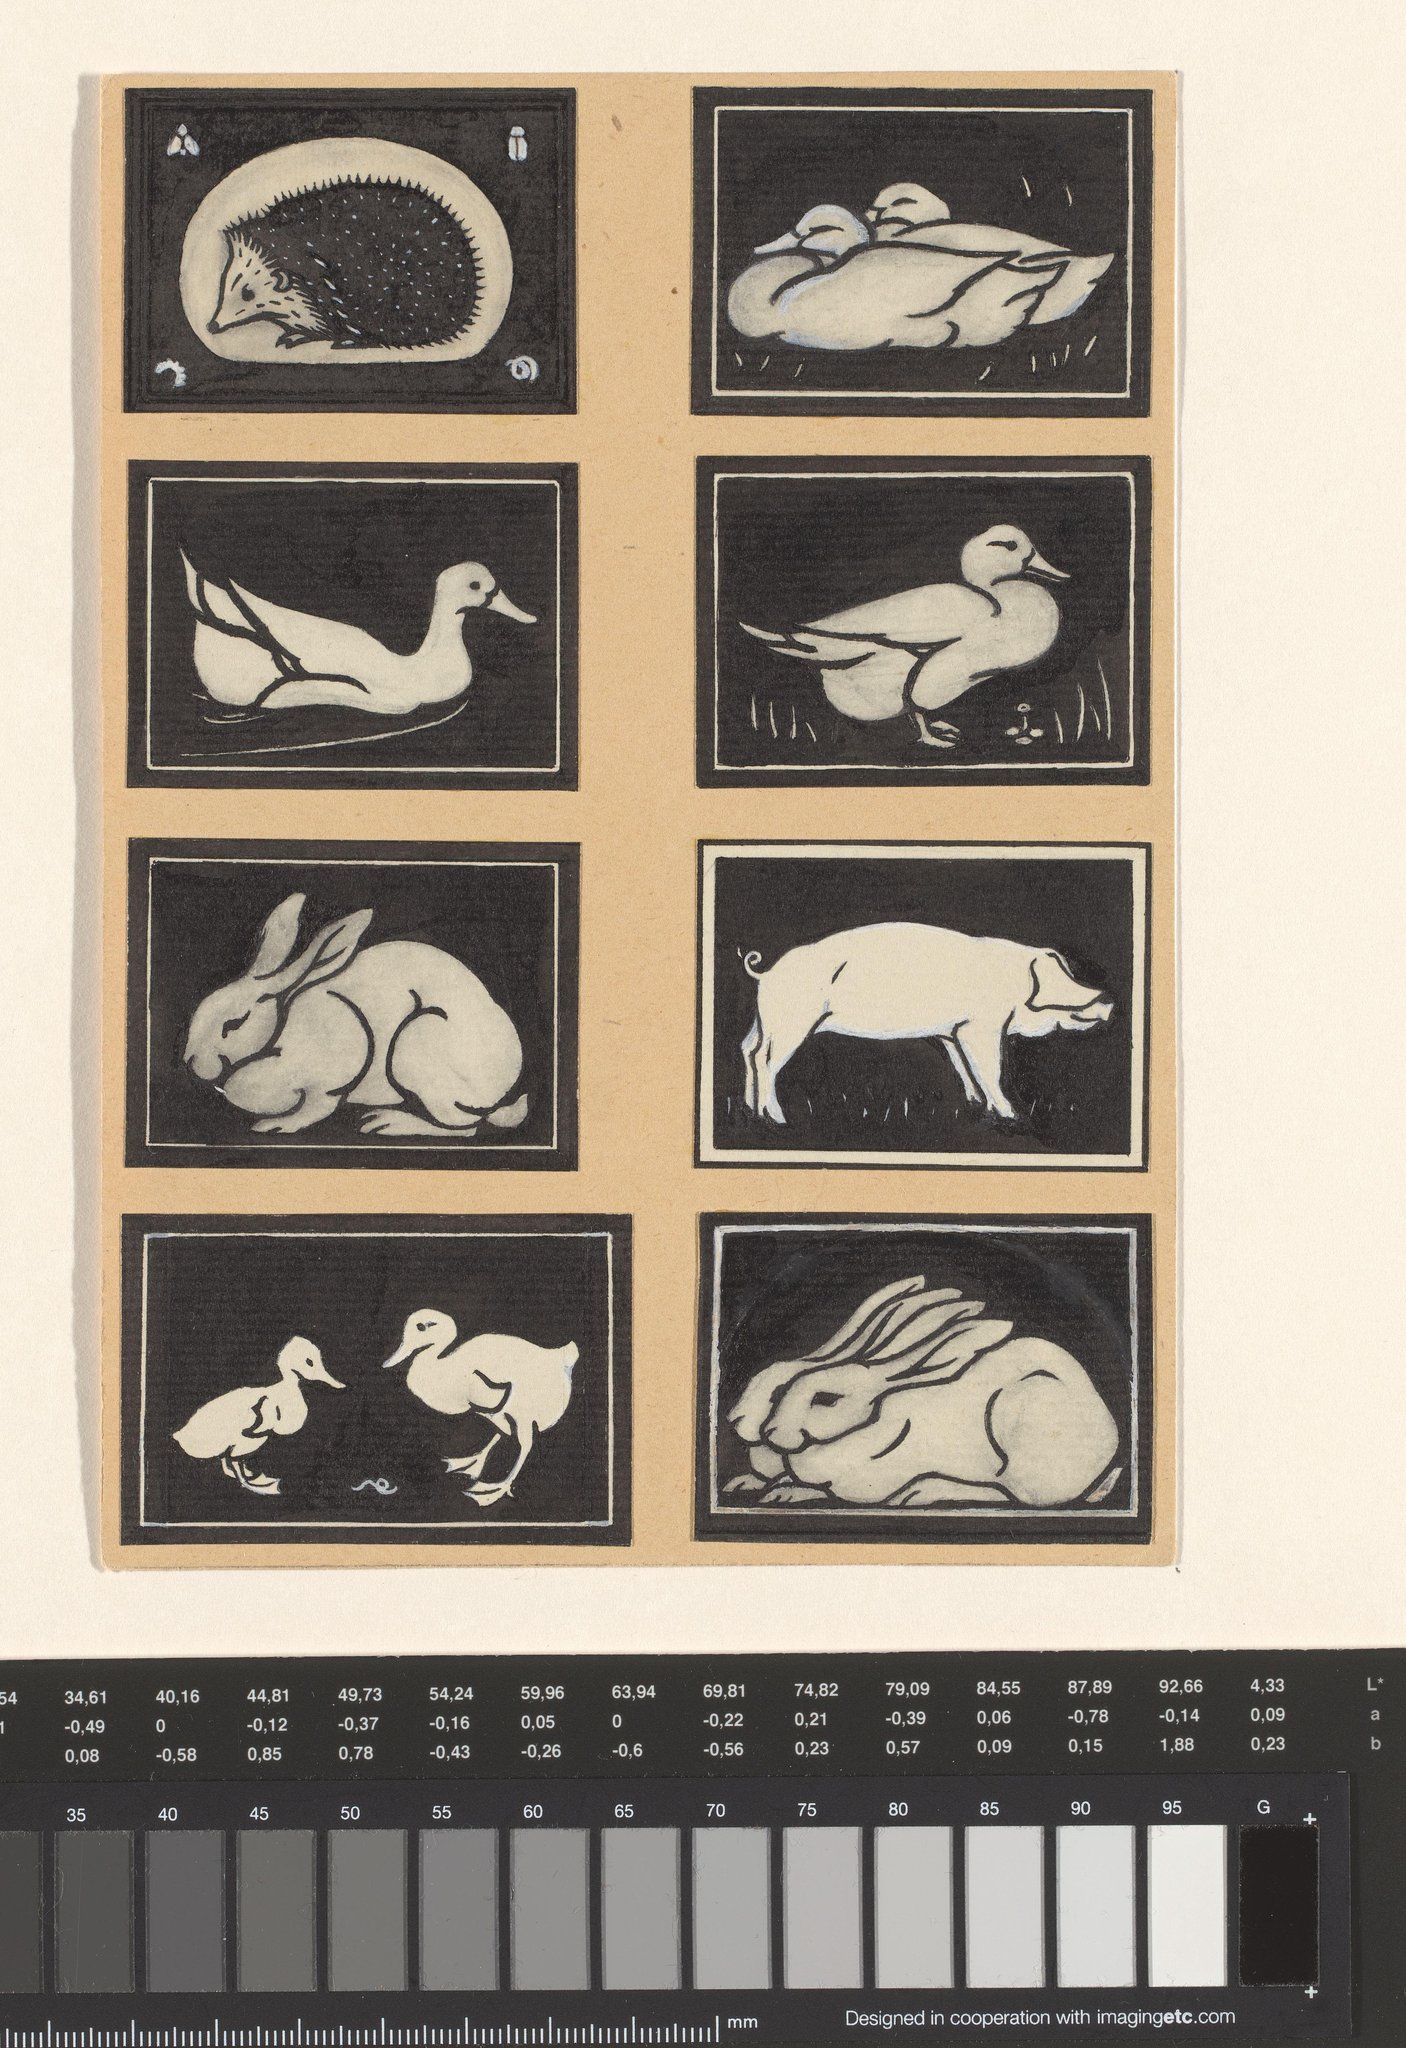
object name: drawing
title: Konijn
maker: julie de graag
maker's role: draughtsman, print maker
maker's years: 1877-1924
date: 1887-1924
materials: ink, paper, pencil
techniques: brush, pen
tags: rodents: rabbit